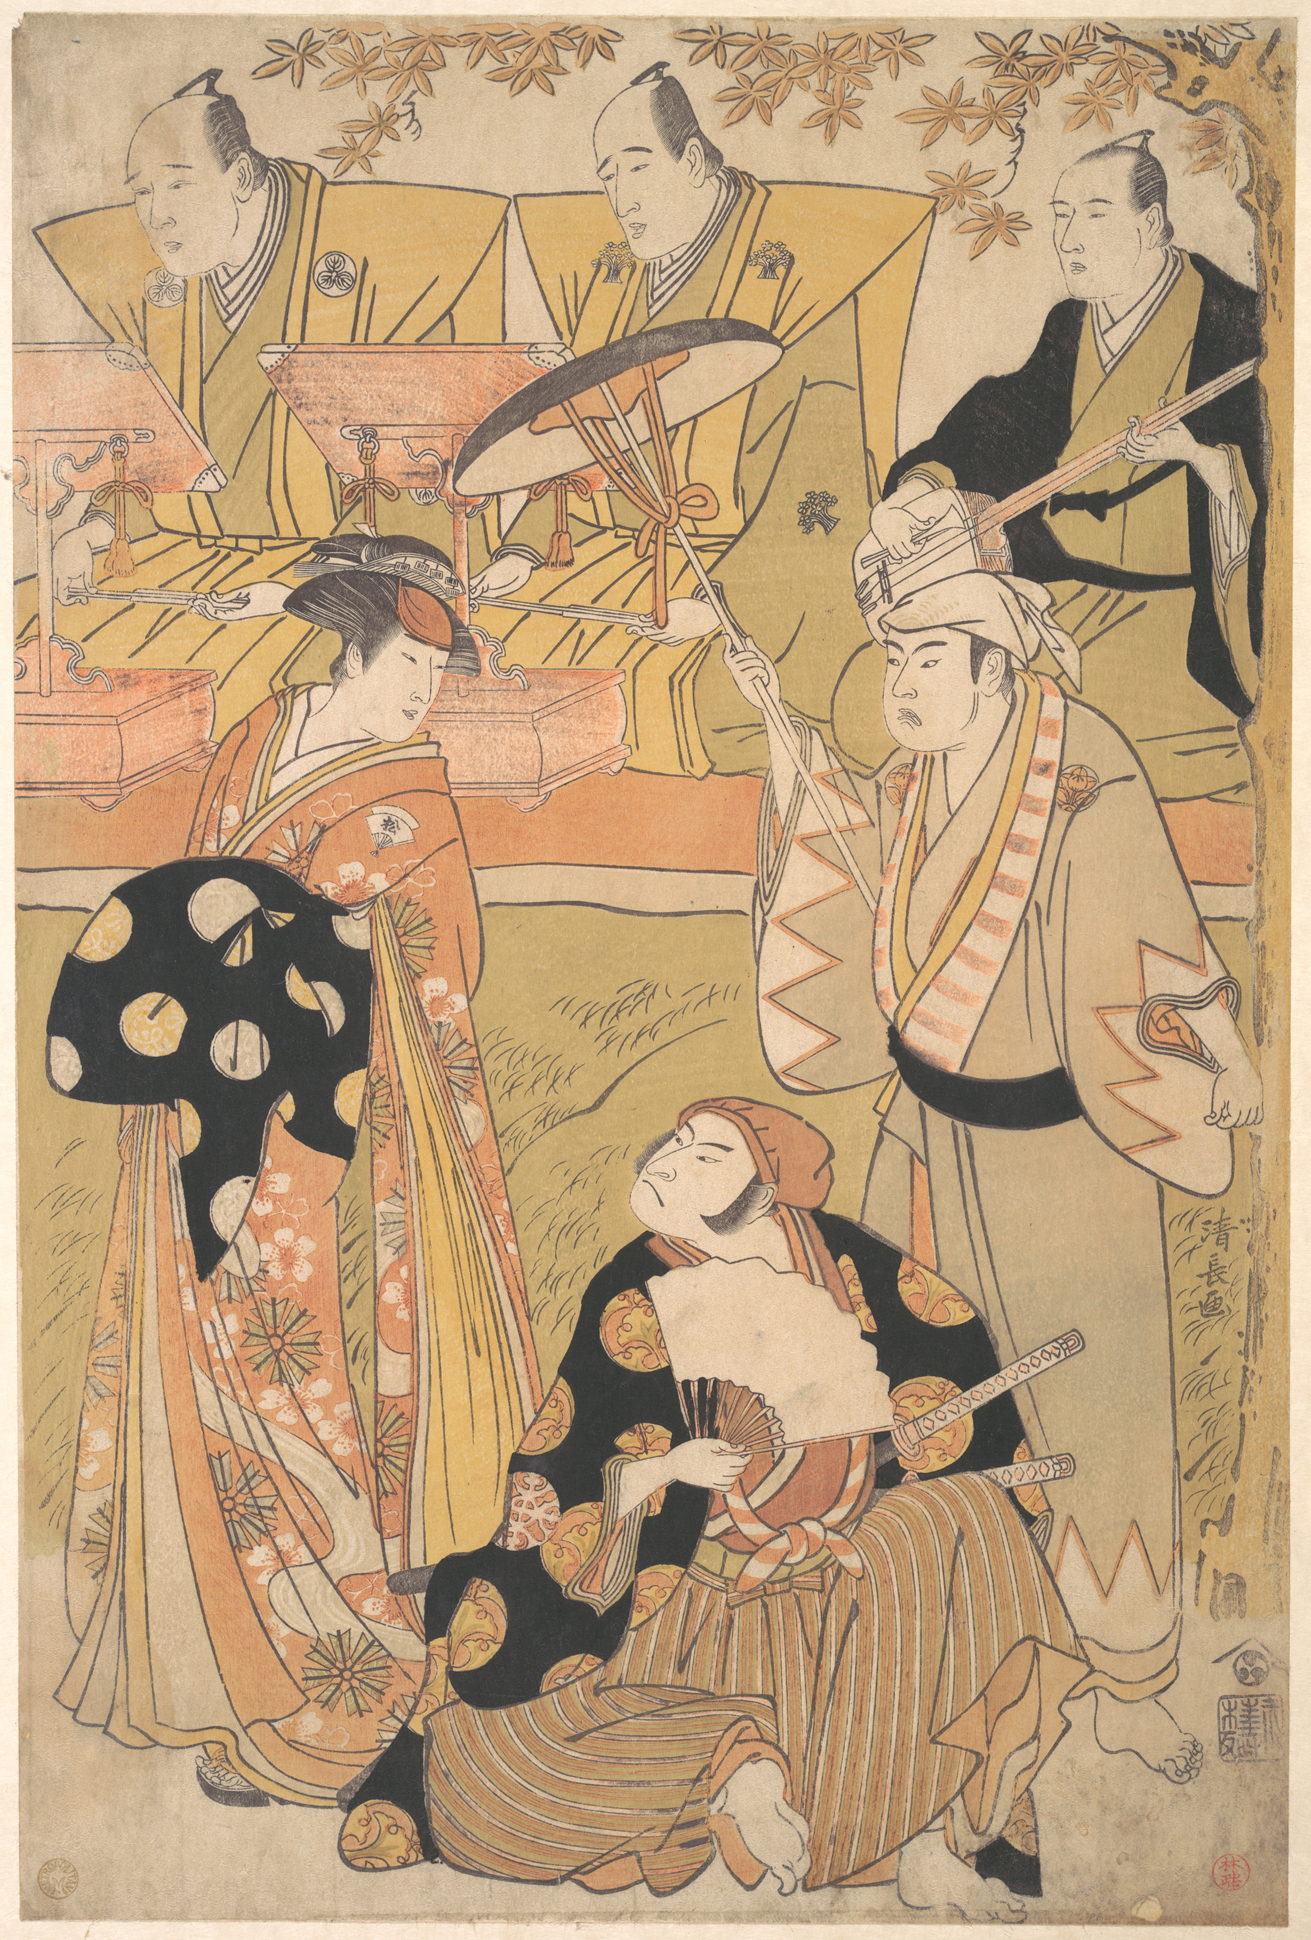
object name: print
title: Onoe Matsusuke I as an Oiran Stands at the Left, Talking to Nakamura Nakazo I as a Samurai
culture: japanese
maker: torii kiyonaga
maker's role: artist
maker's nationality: japanese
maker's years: 1752-1815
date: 1788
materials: ink, paper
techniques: woodblock print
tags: fans,men,women